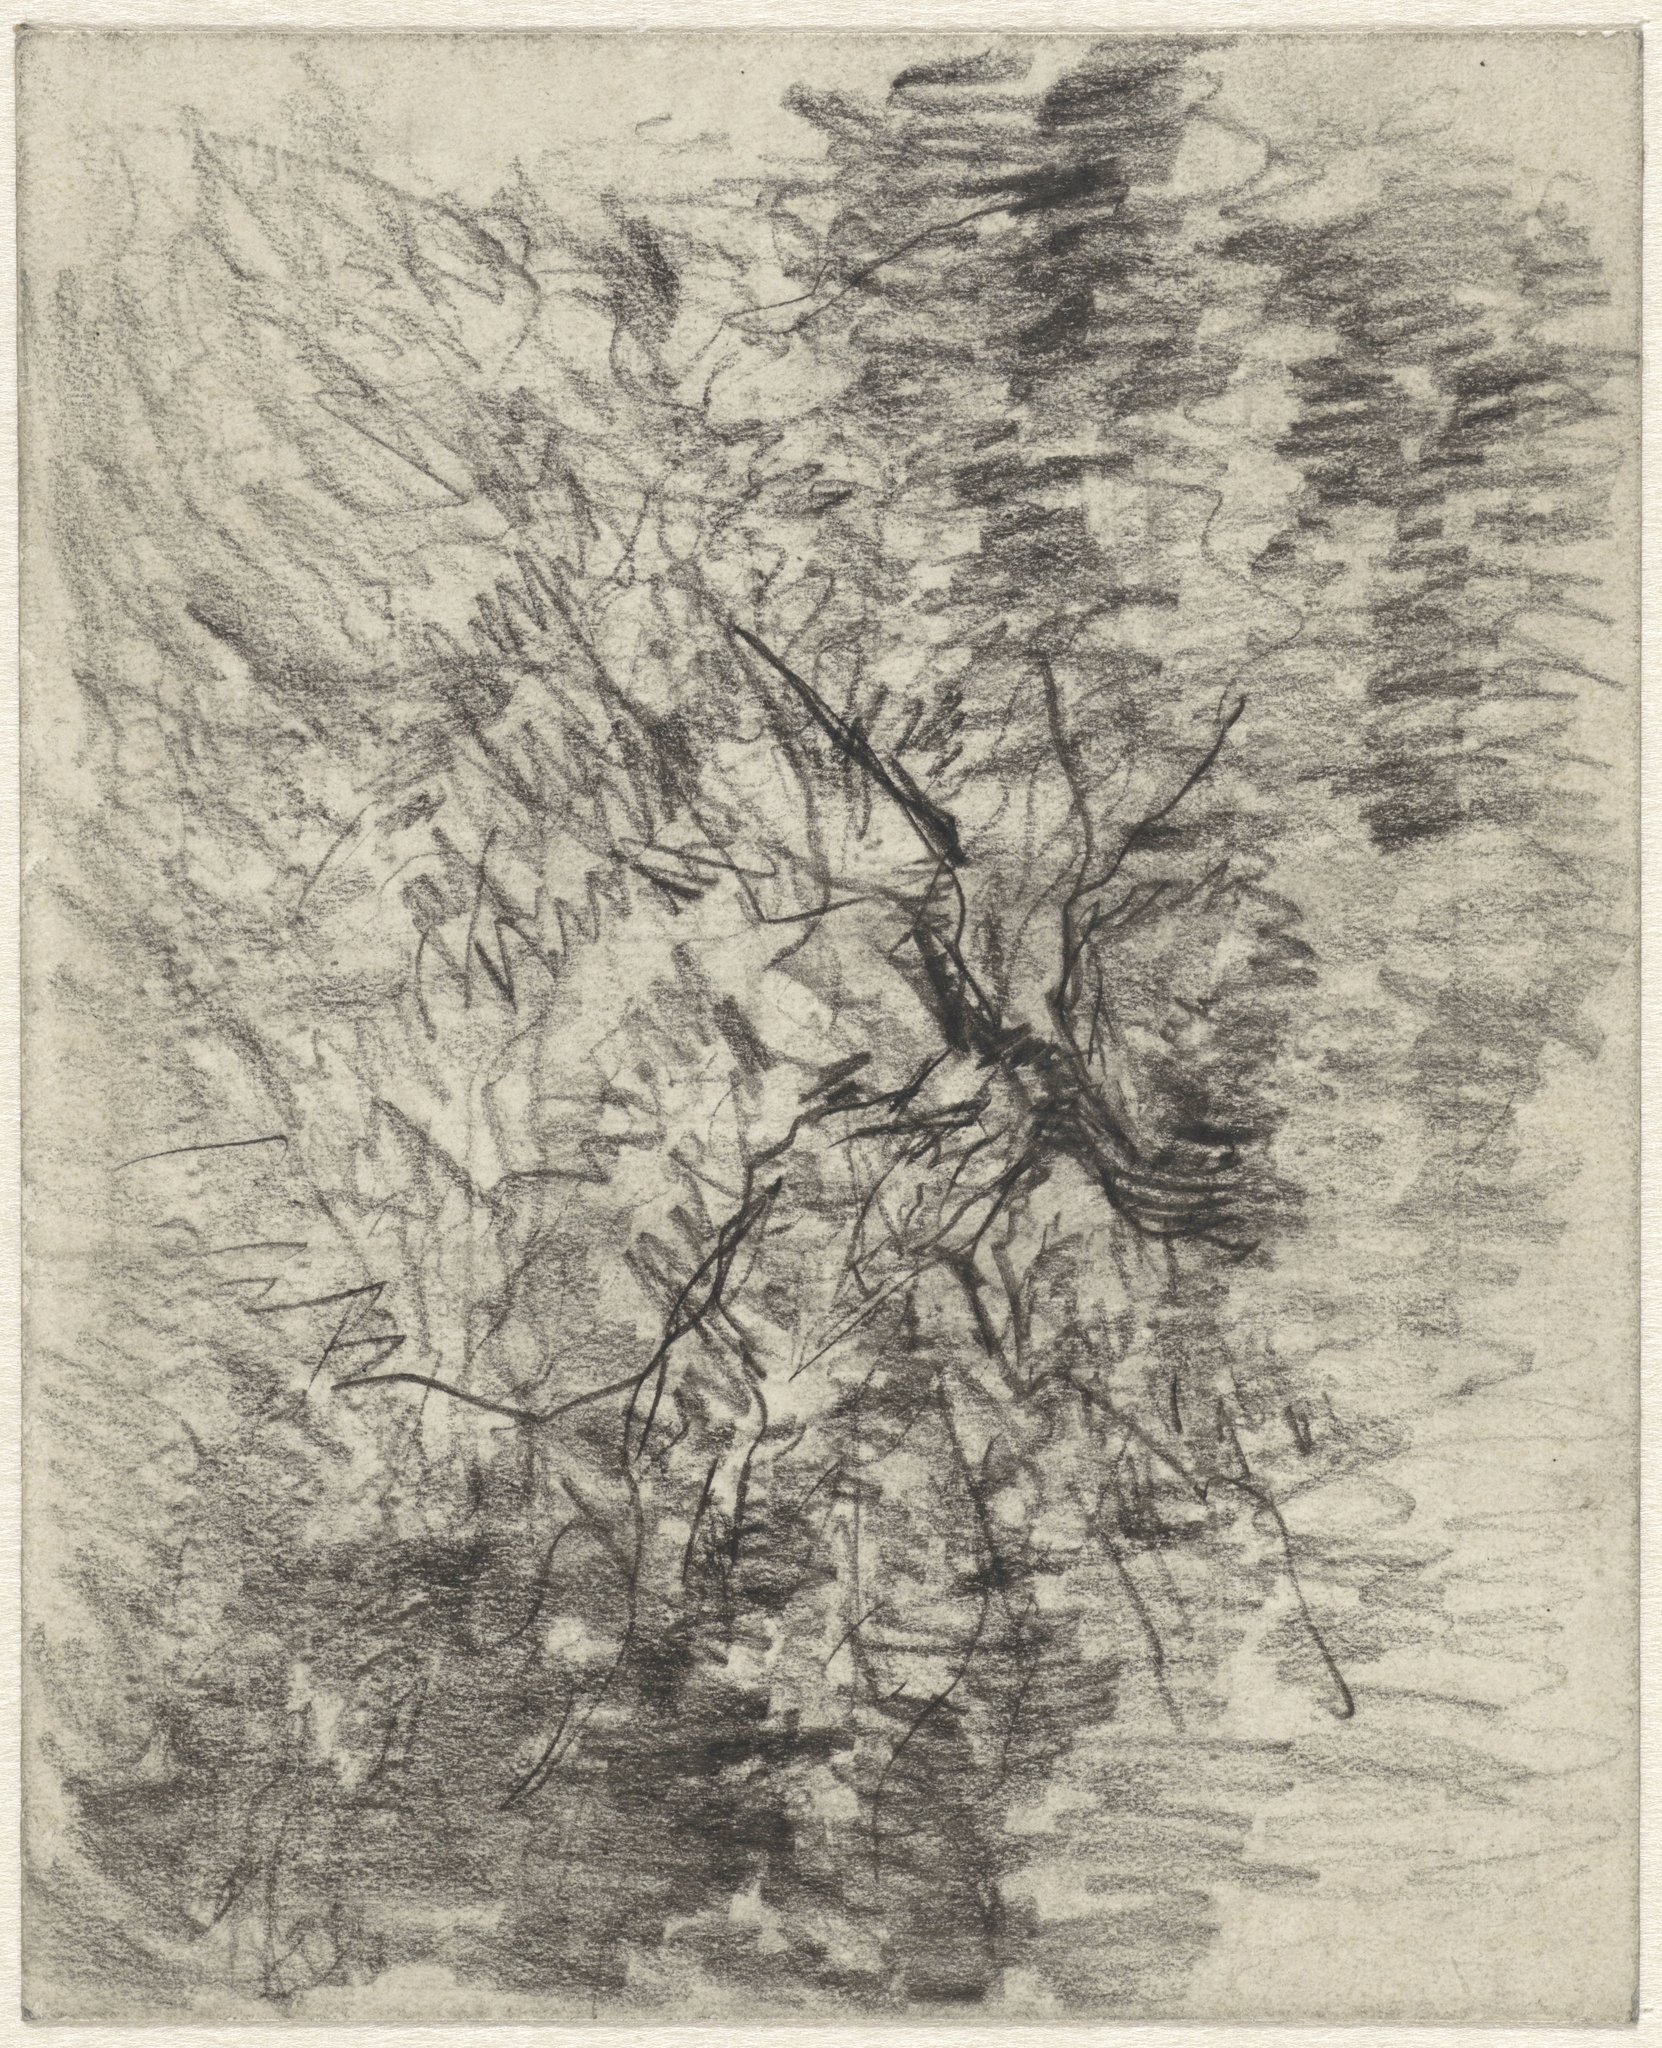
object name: invitation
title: Landschap met struik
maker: egbert rubertus derk schaap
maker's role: draughtsman, painter, print maker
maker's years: 1862-1939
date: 1872-1939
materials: cardboard, chalk